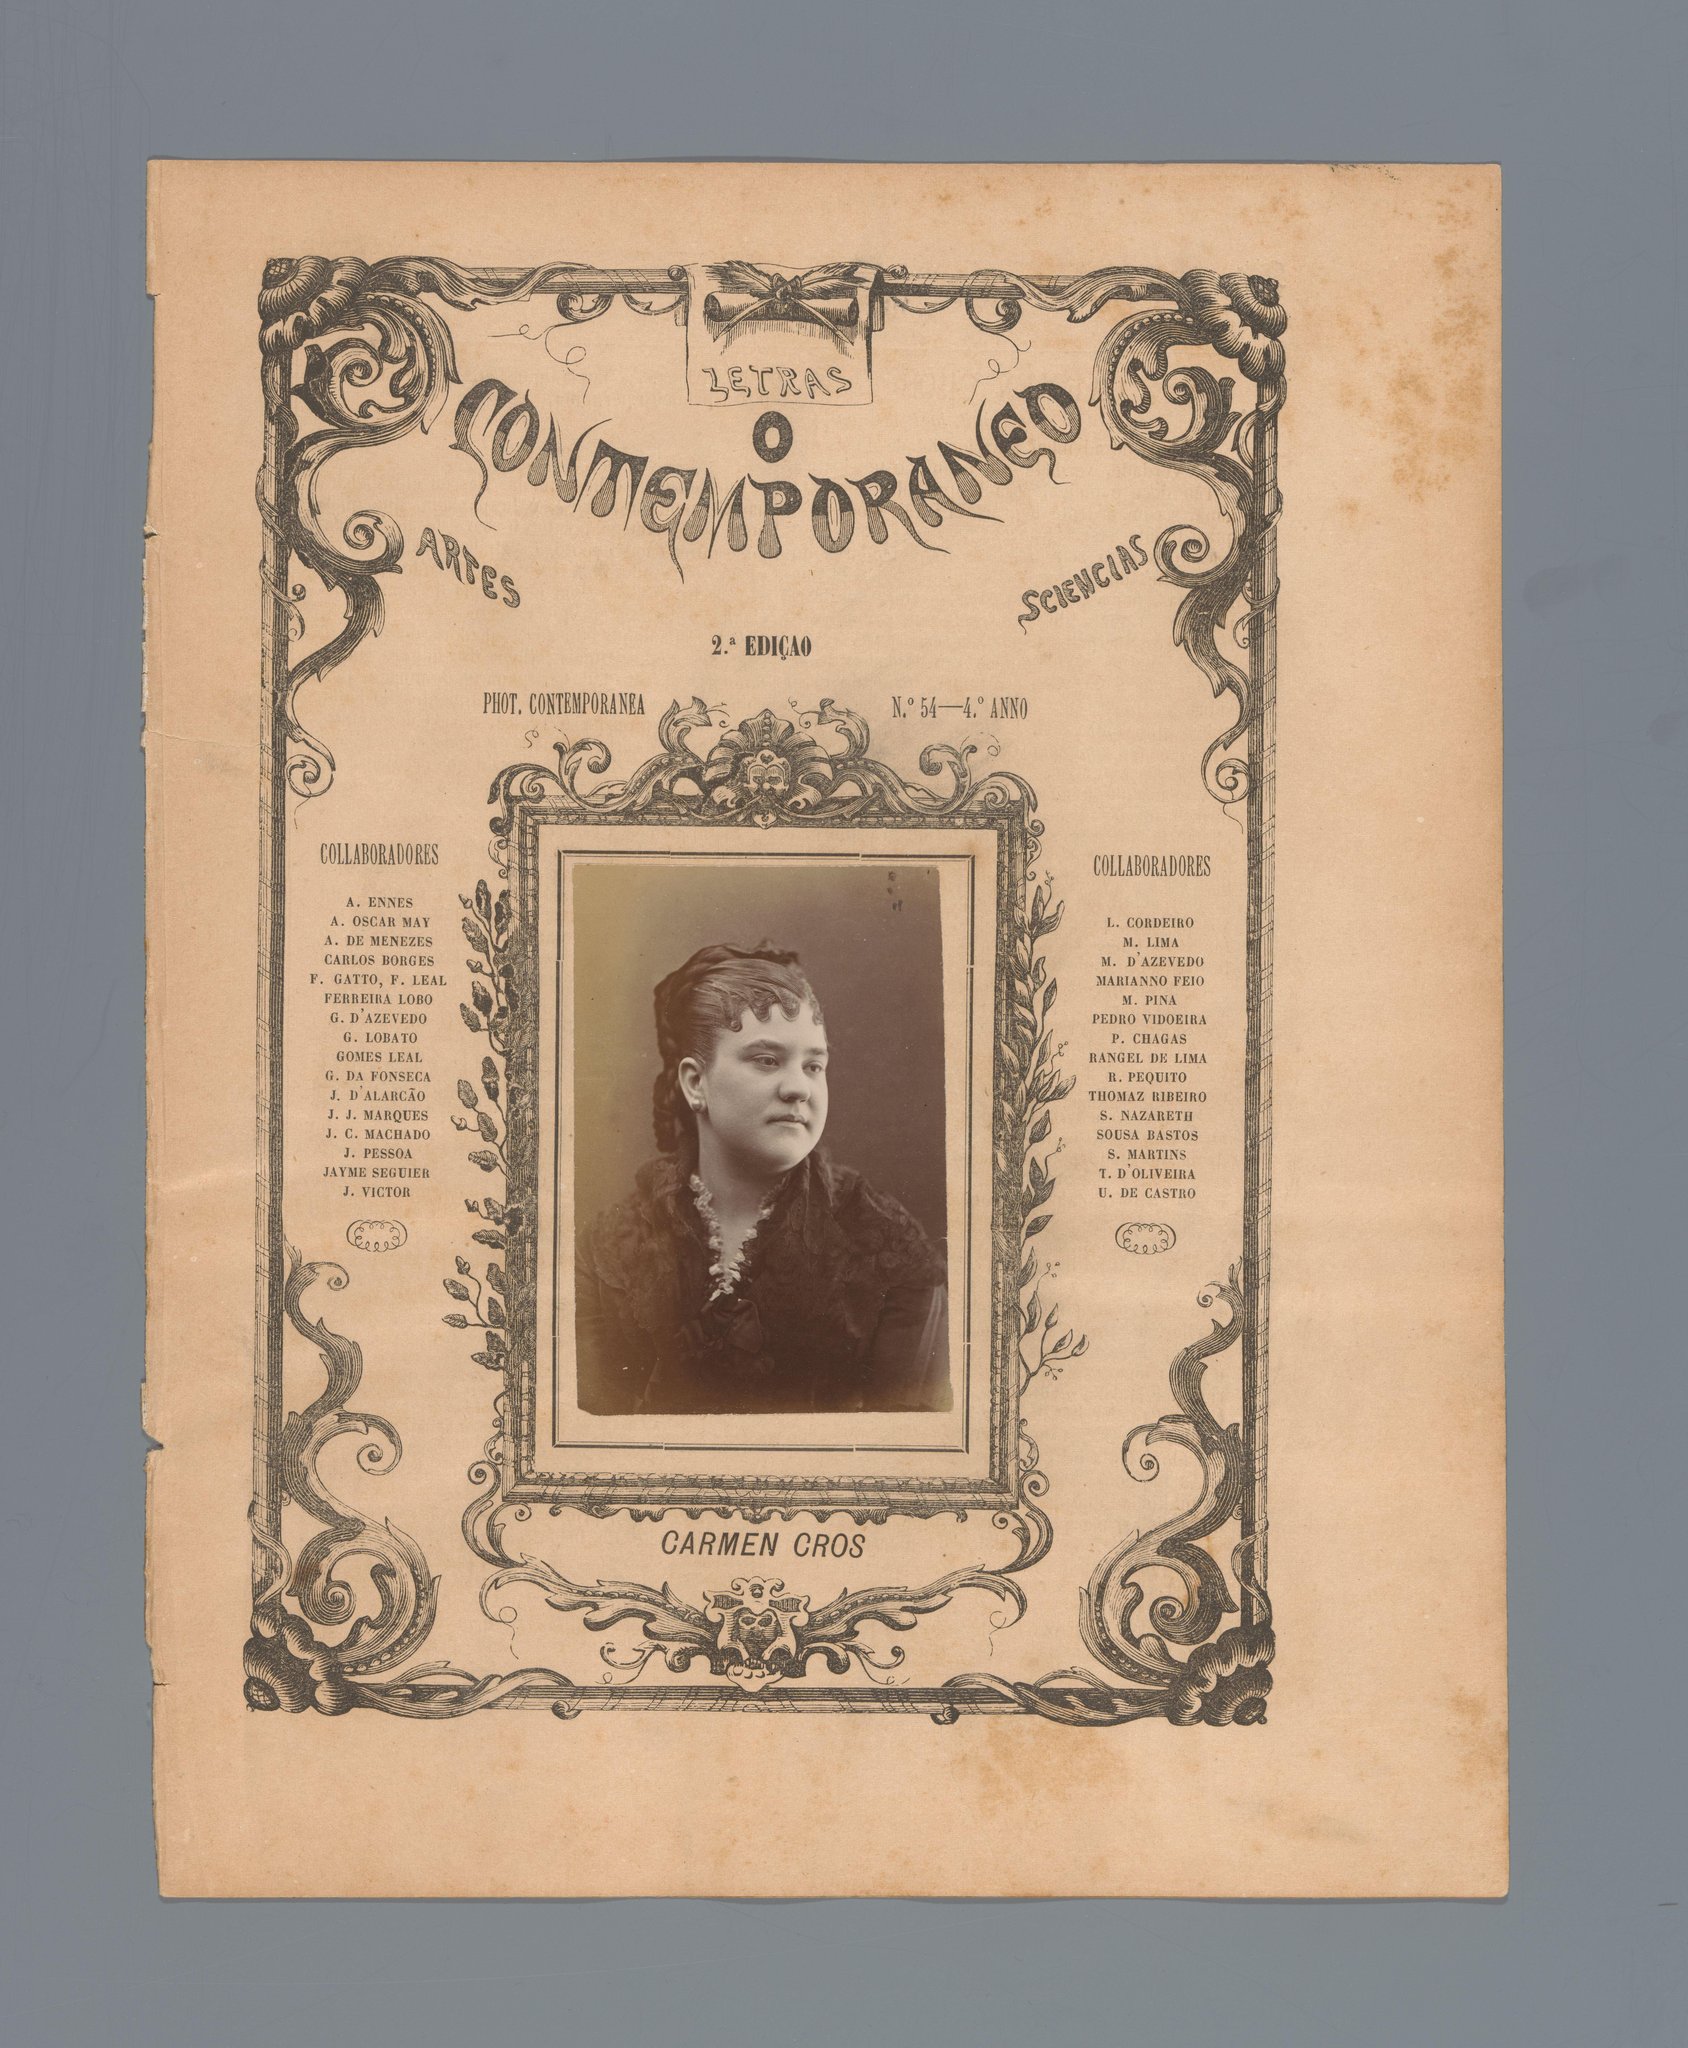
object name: photograph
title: O contemporaneo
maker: alfred fillon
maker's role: fotograaf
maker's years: 1825-1881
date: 1873-1878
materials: paper, photographic support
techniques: albumen print, printing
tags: historical persons - bb - woman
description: Op de voorpagina bevindt zich een portret van Carmen Cros.